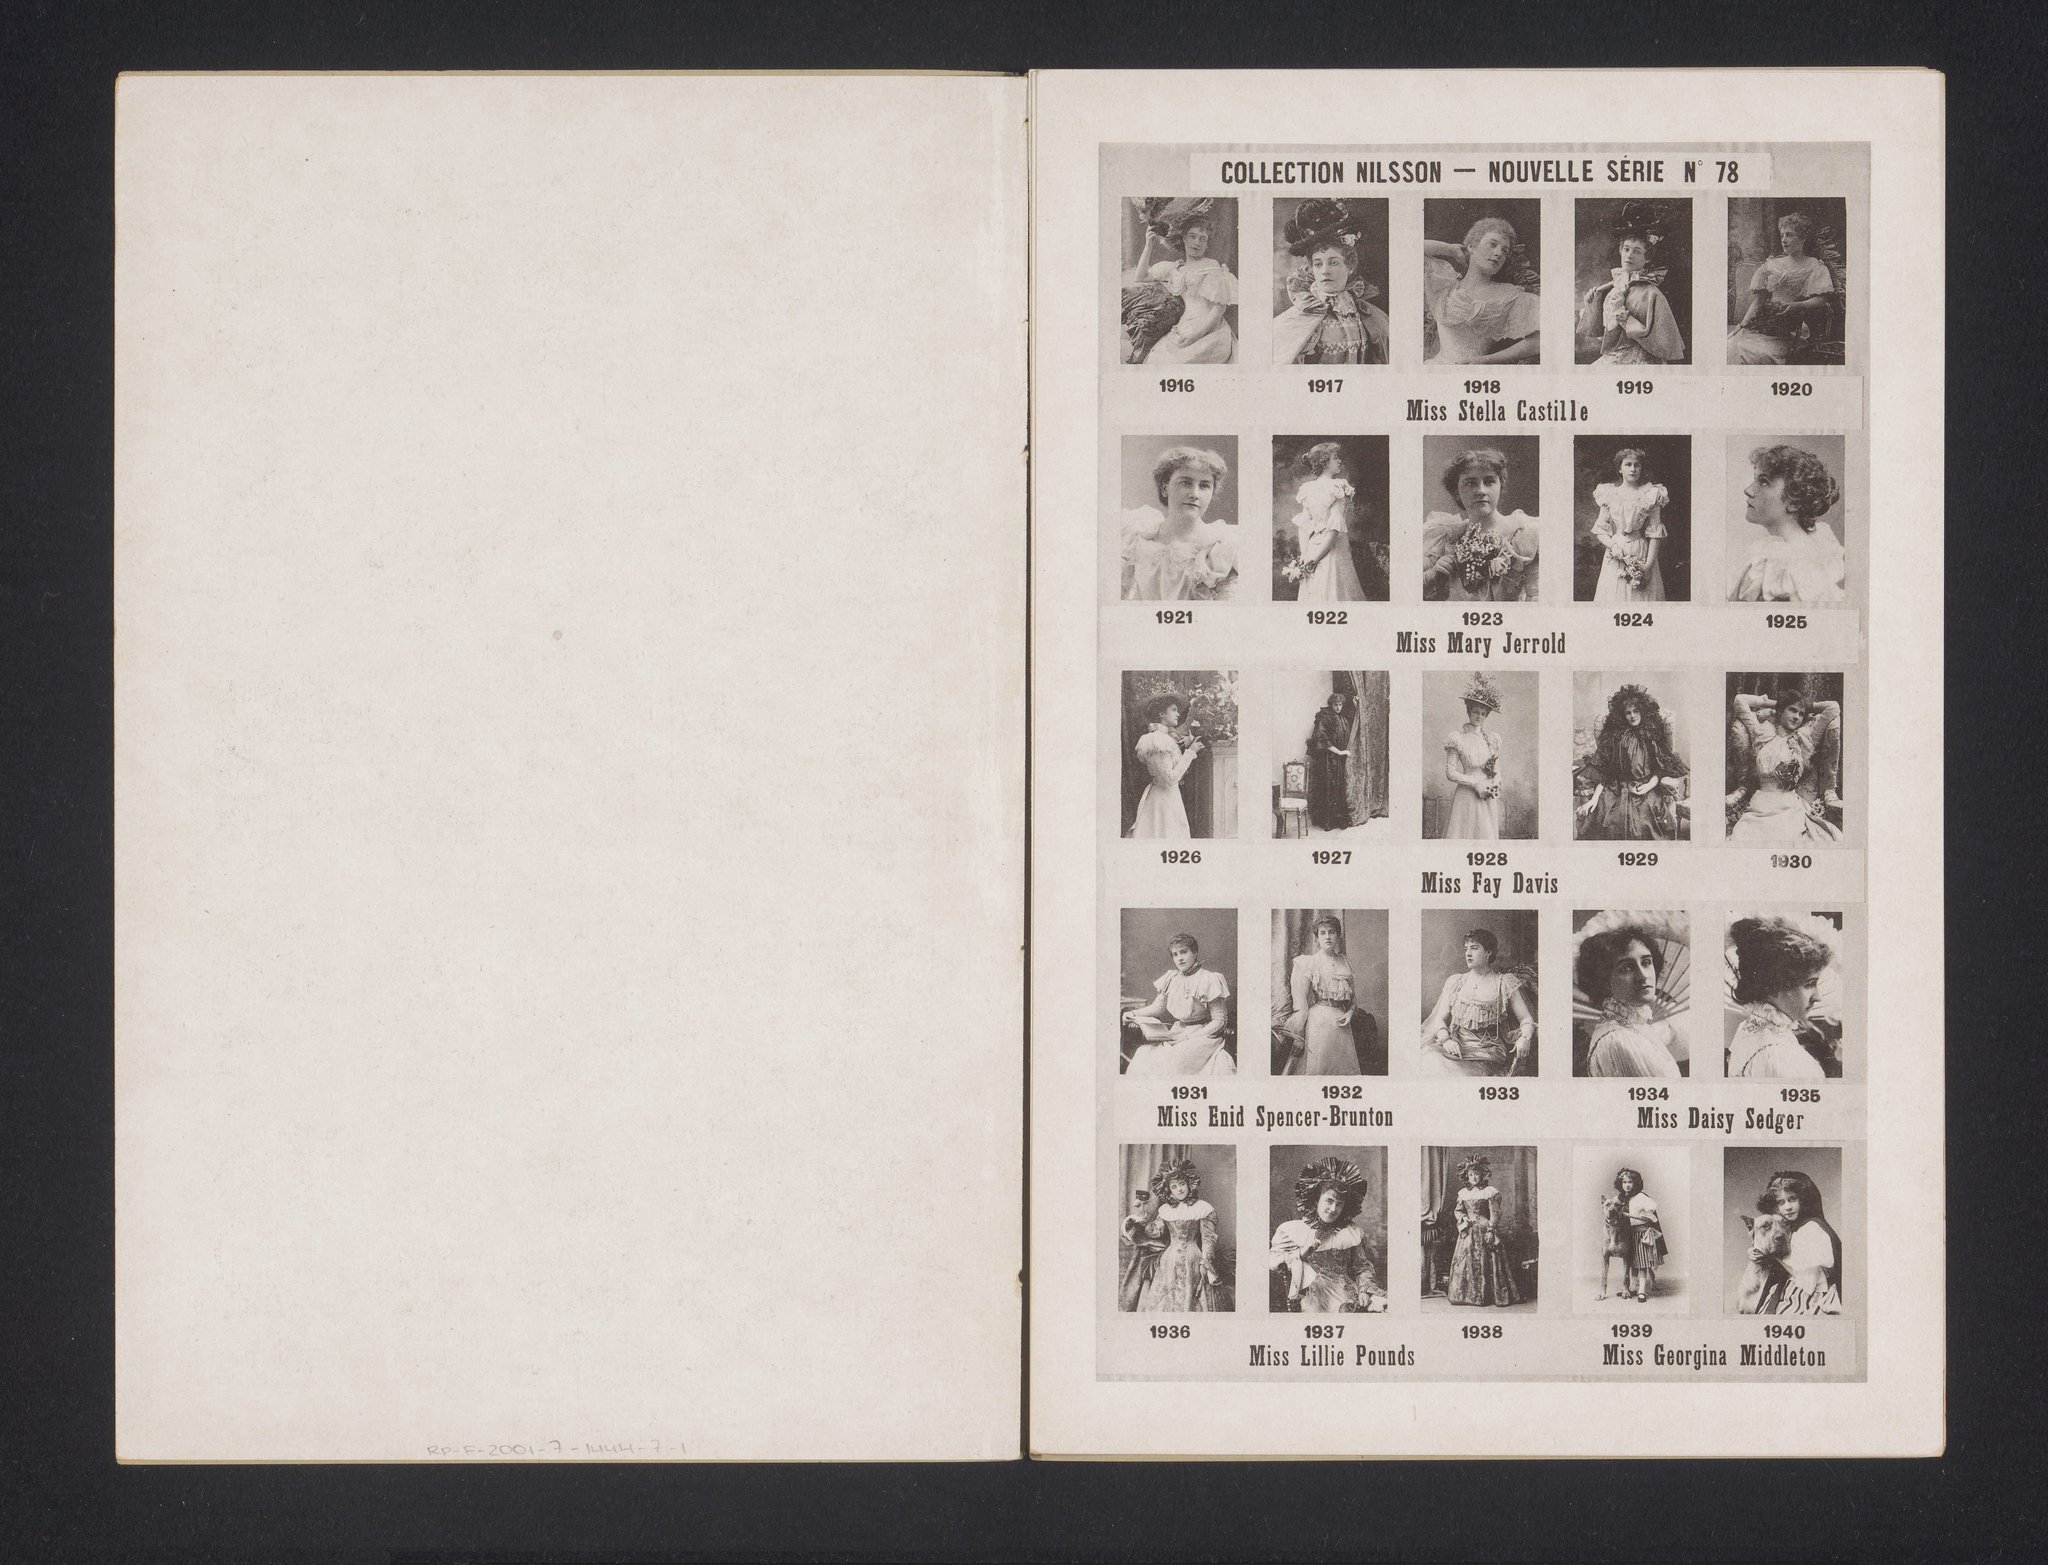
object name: photomechanical print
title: 25 portretten van Stella Castille, Mary Jerrold, Fay Davis, Enid Spencer-Brunton, Daisy Sedger, Lillie Pounds en Georgina Middleton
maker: Anonymous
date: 1892-1897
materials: paper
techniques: photograph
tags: historical persons - bb - woman, portrait of actor, actress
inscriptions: number: ‘No 78’